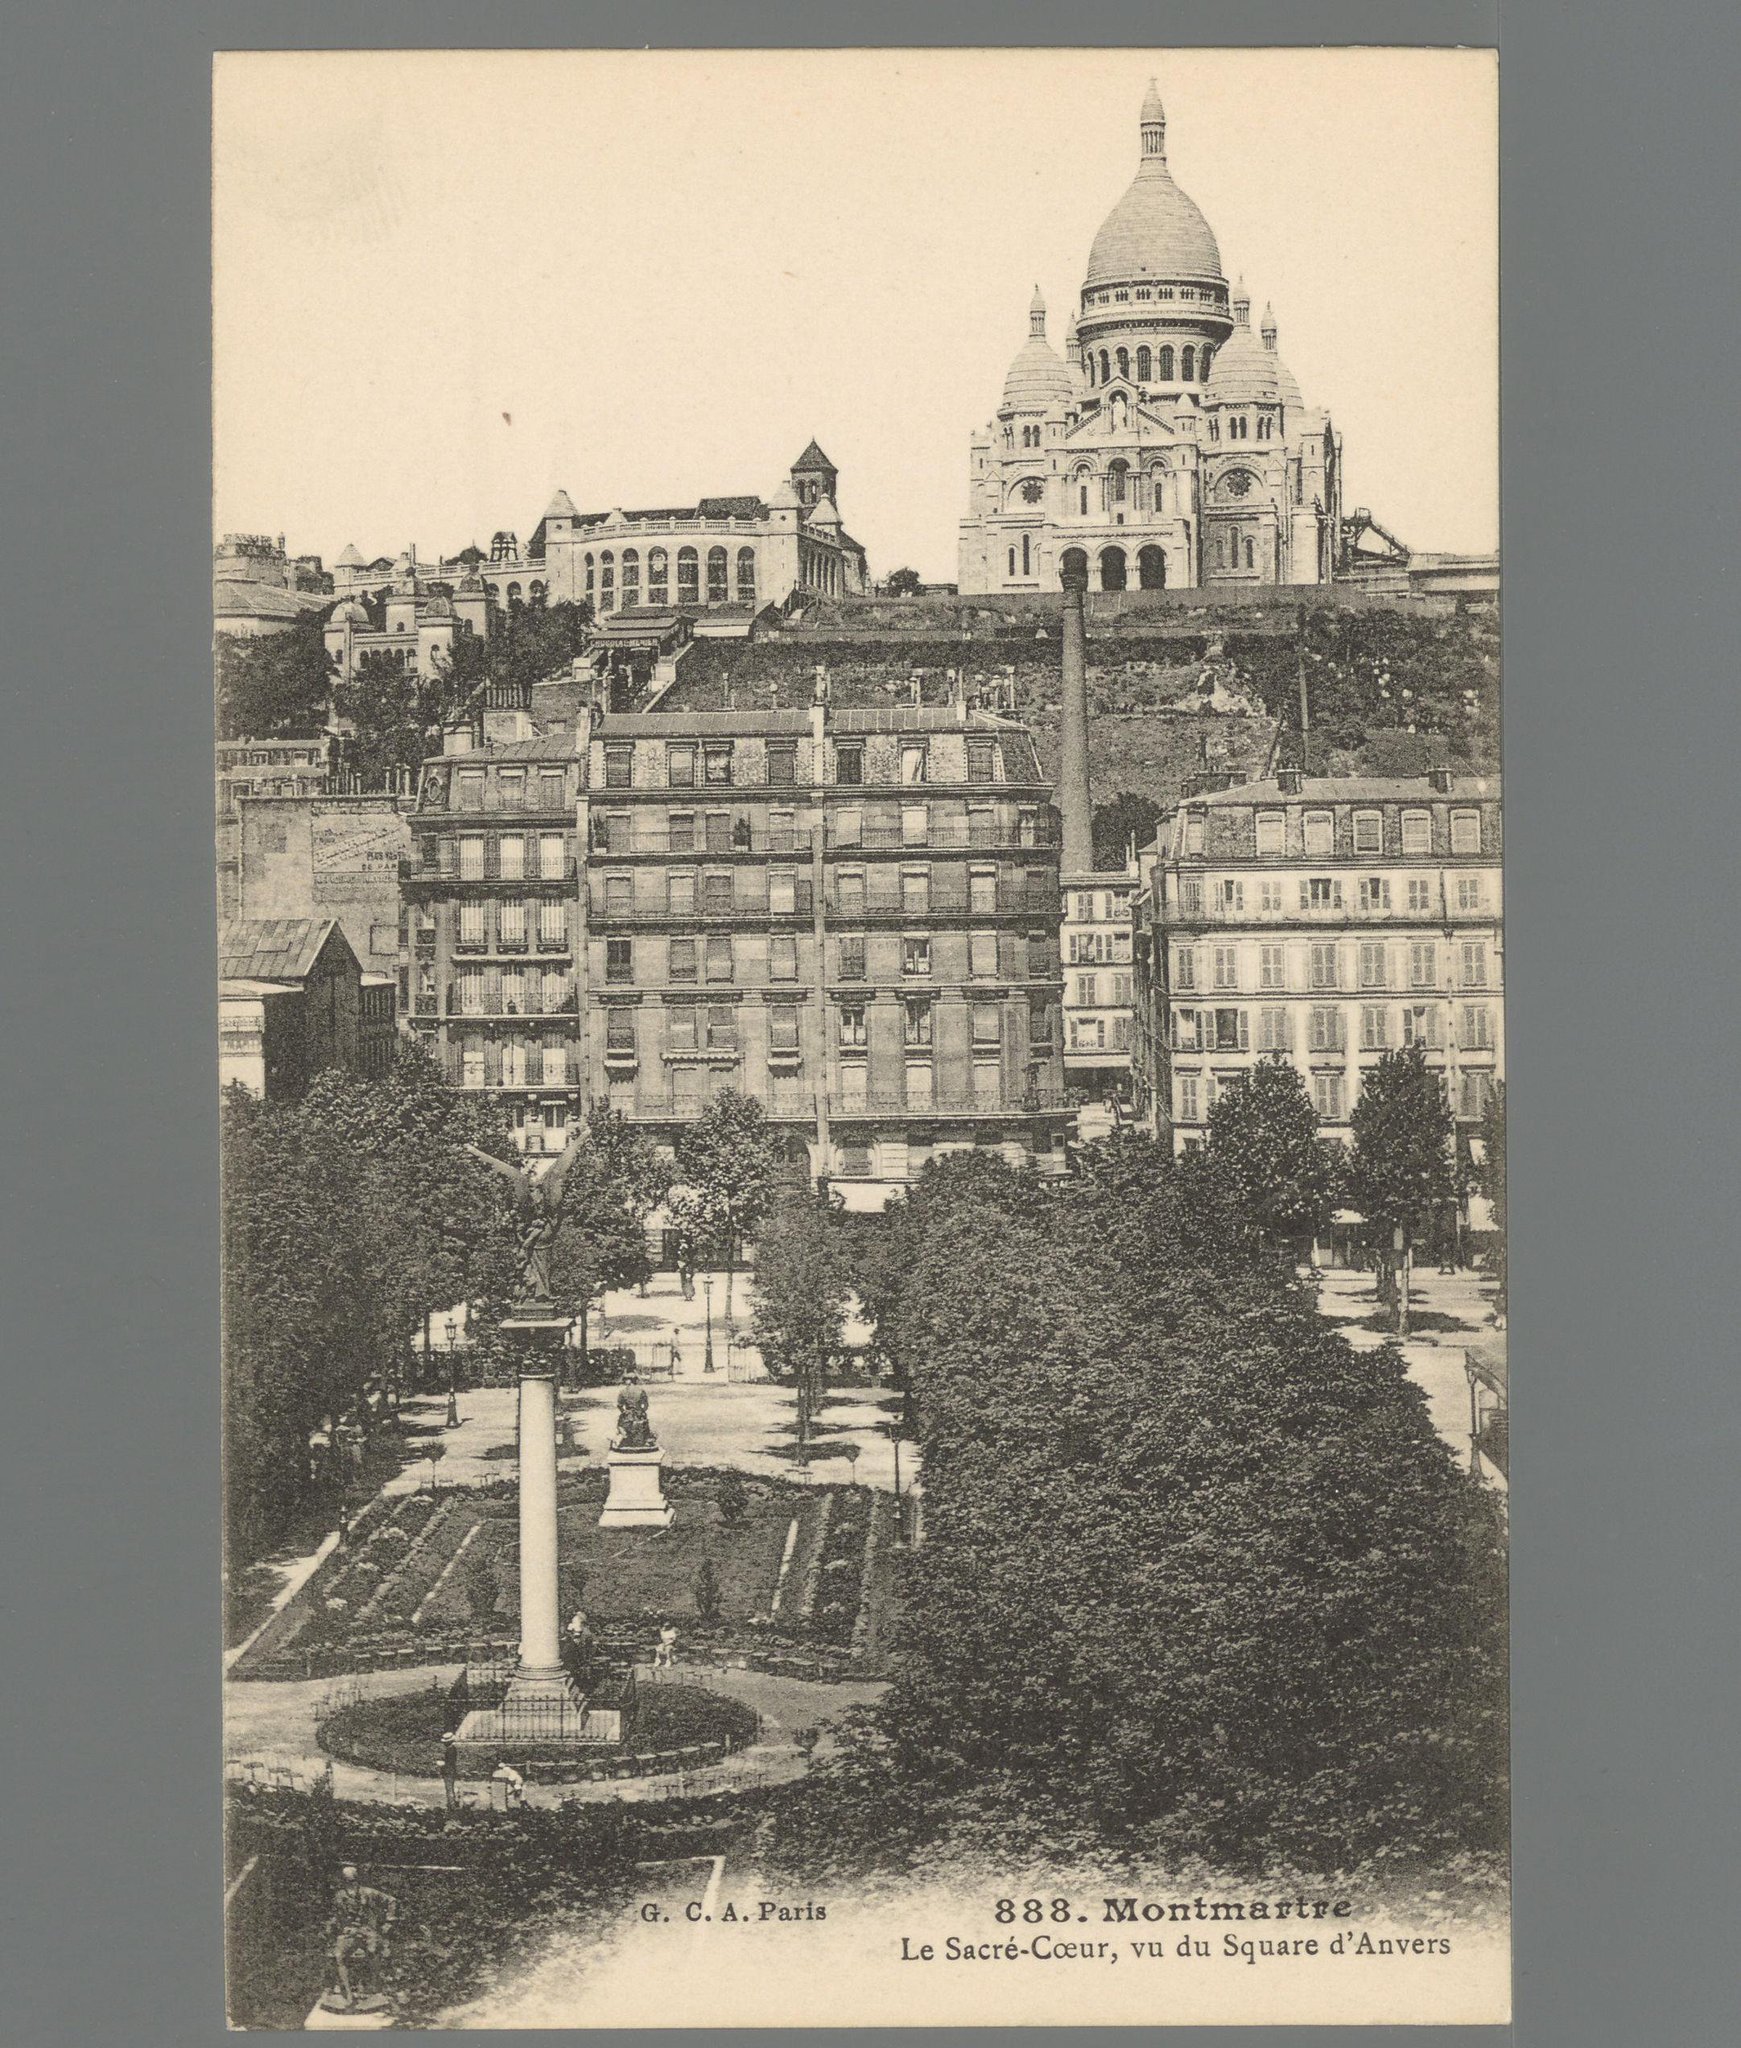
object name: ansichtkaart, prentbriefkaart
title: Montmartre. Le Sacré-Coeur, vu du Square d'Anvers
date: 1903-1920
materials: cardboard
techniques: photograph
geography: paris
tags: city-view, and landscape with man-made constructions, church (exterior)